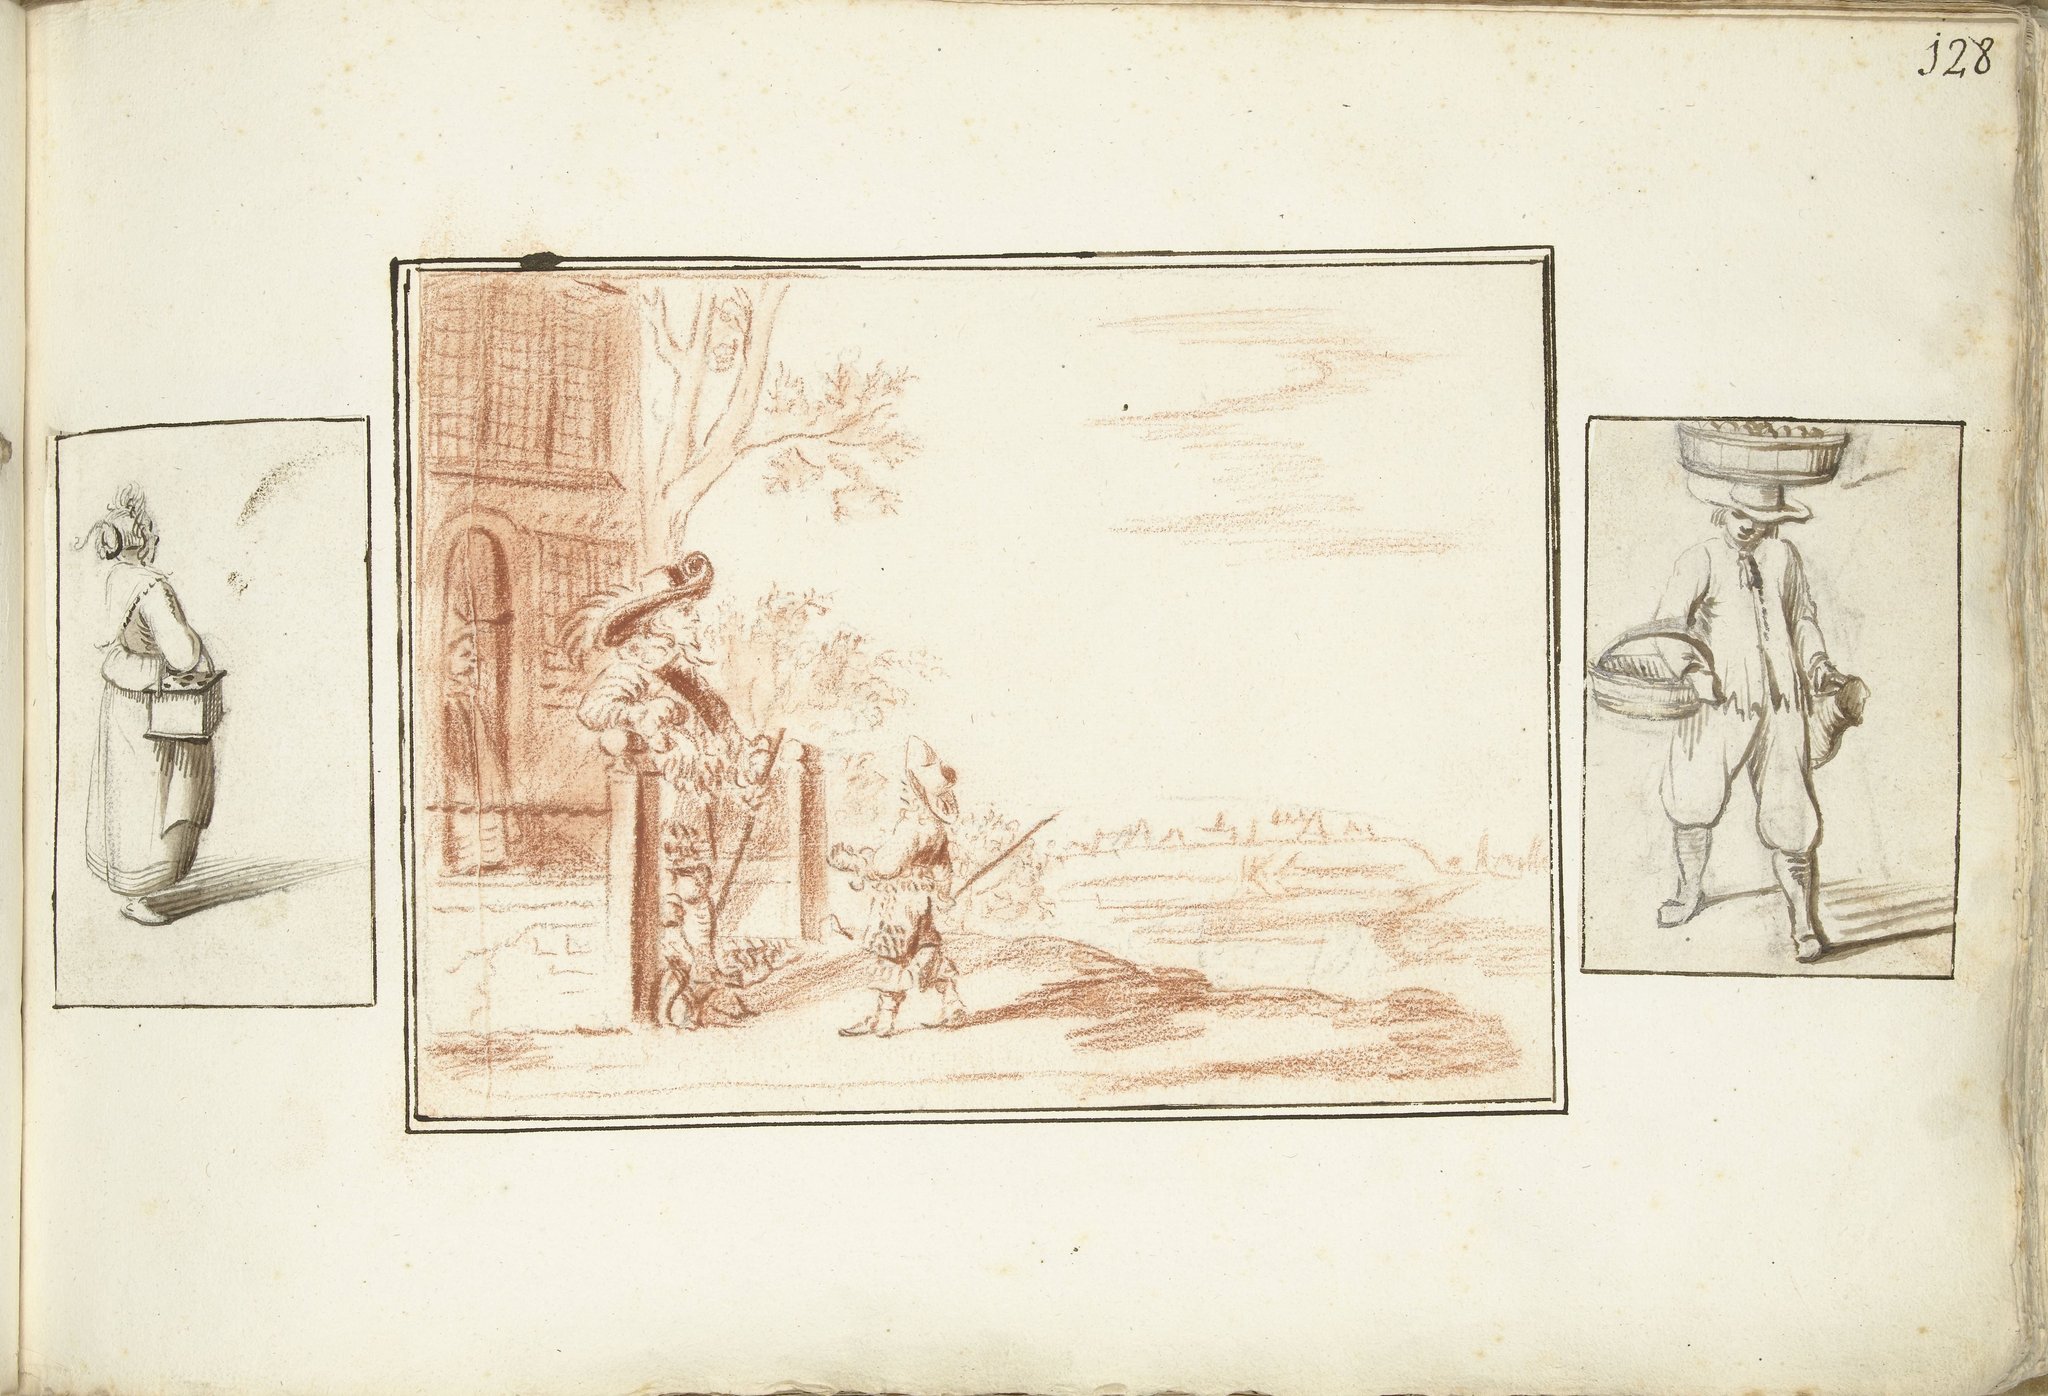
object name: drawing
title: Vrouw met een stoof, twee mannen bij een landshuis en een man met manden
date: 1648-1687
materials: chalk, ink, paper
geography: zwolle